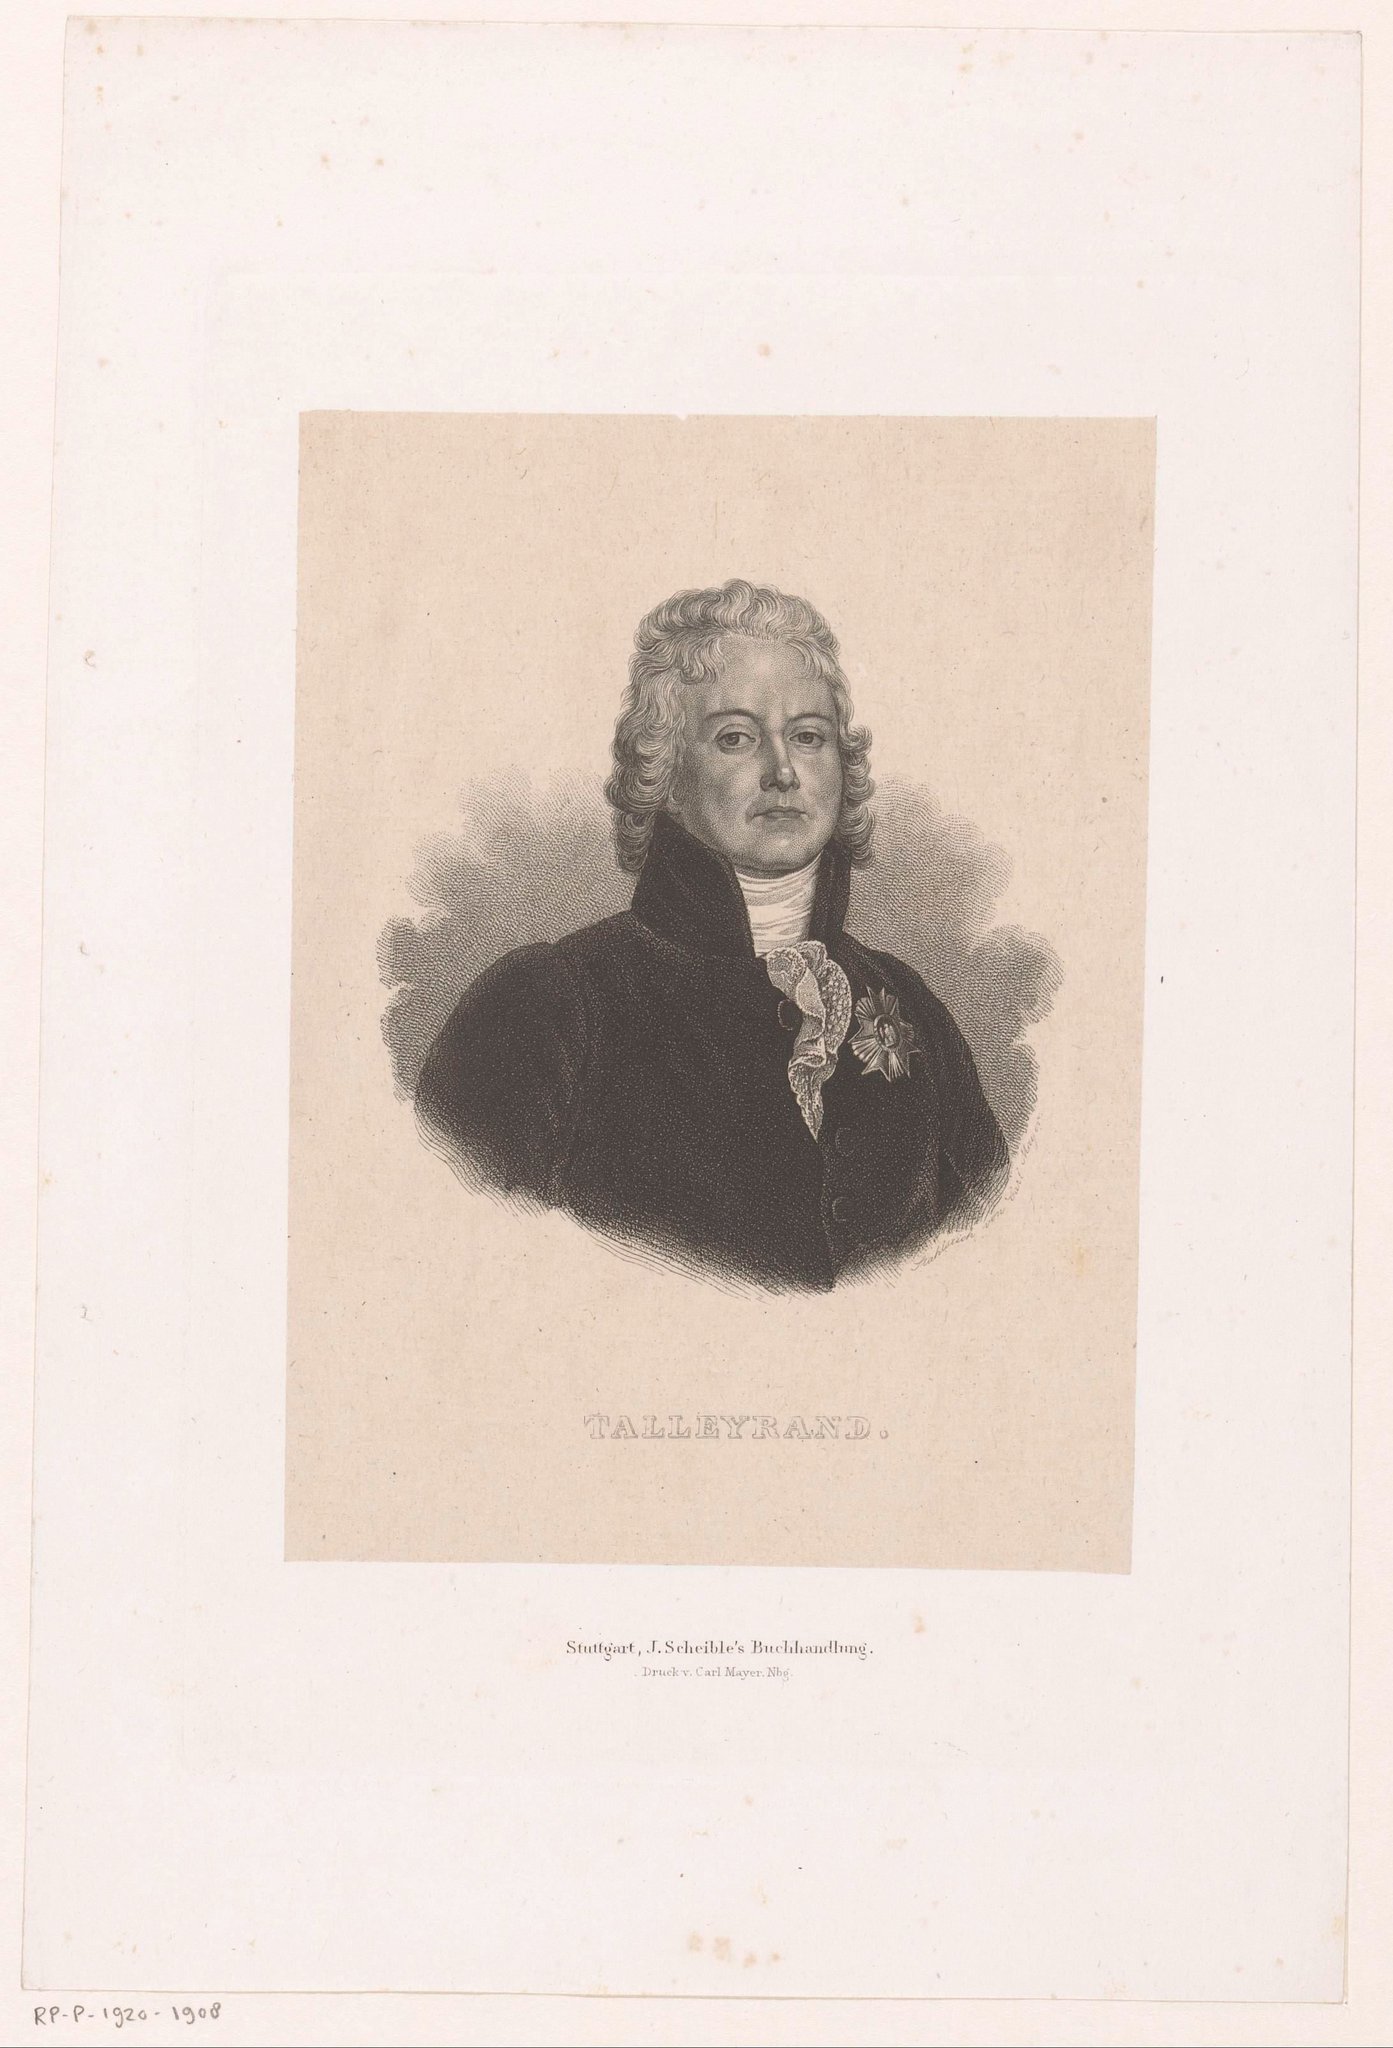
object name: print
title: Portret van Charles Maurice hertog van Talleyrand-Périgord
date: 1808-1868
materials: paper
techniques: engraving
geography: stuttgart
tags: paris, politician, charles maurice hertog van talleyrand-périgord, historical persons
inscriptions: collector's mark: Lugt 2228